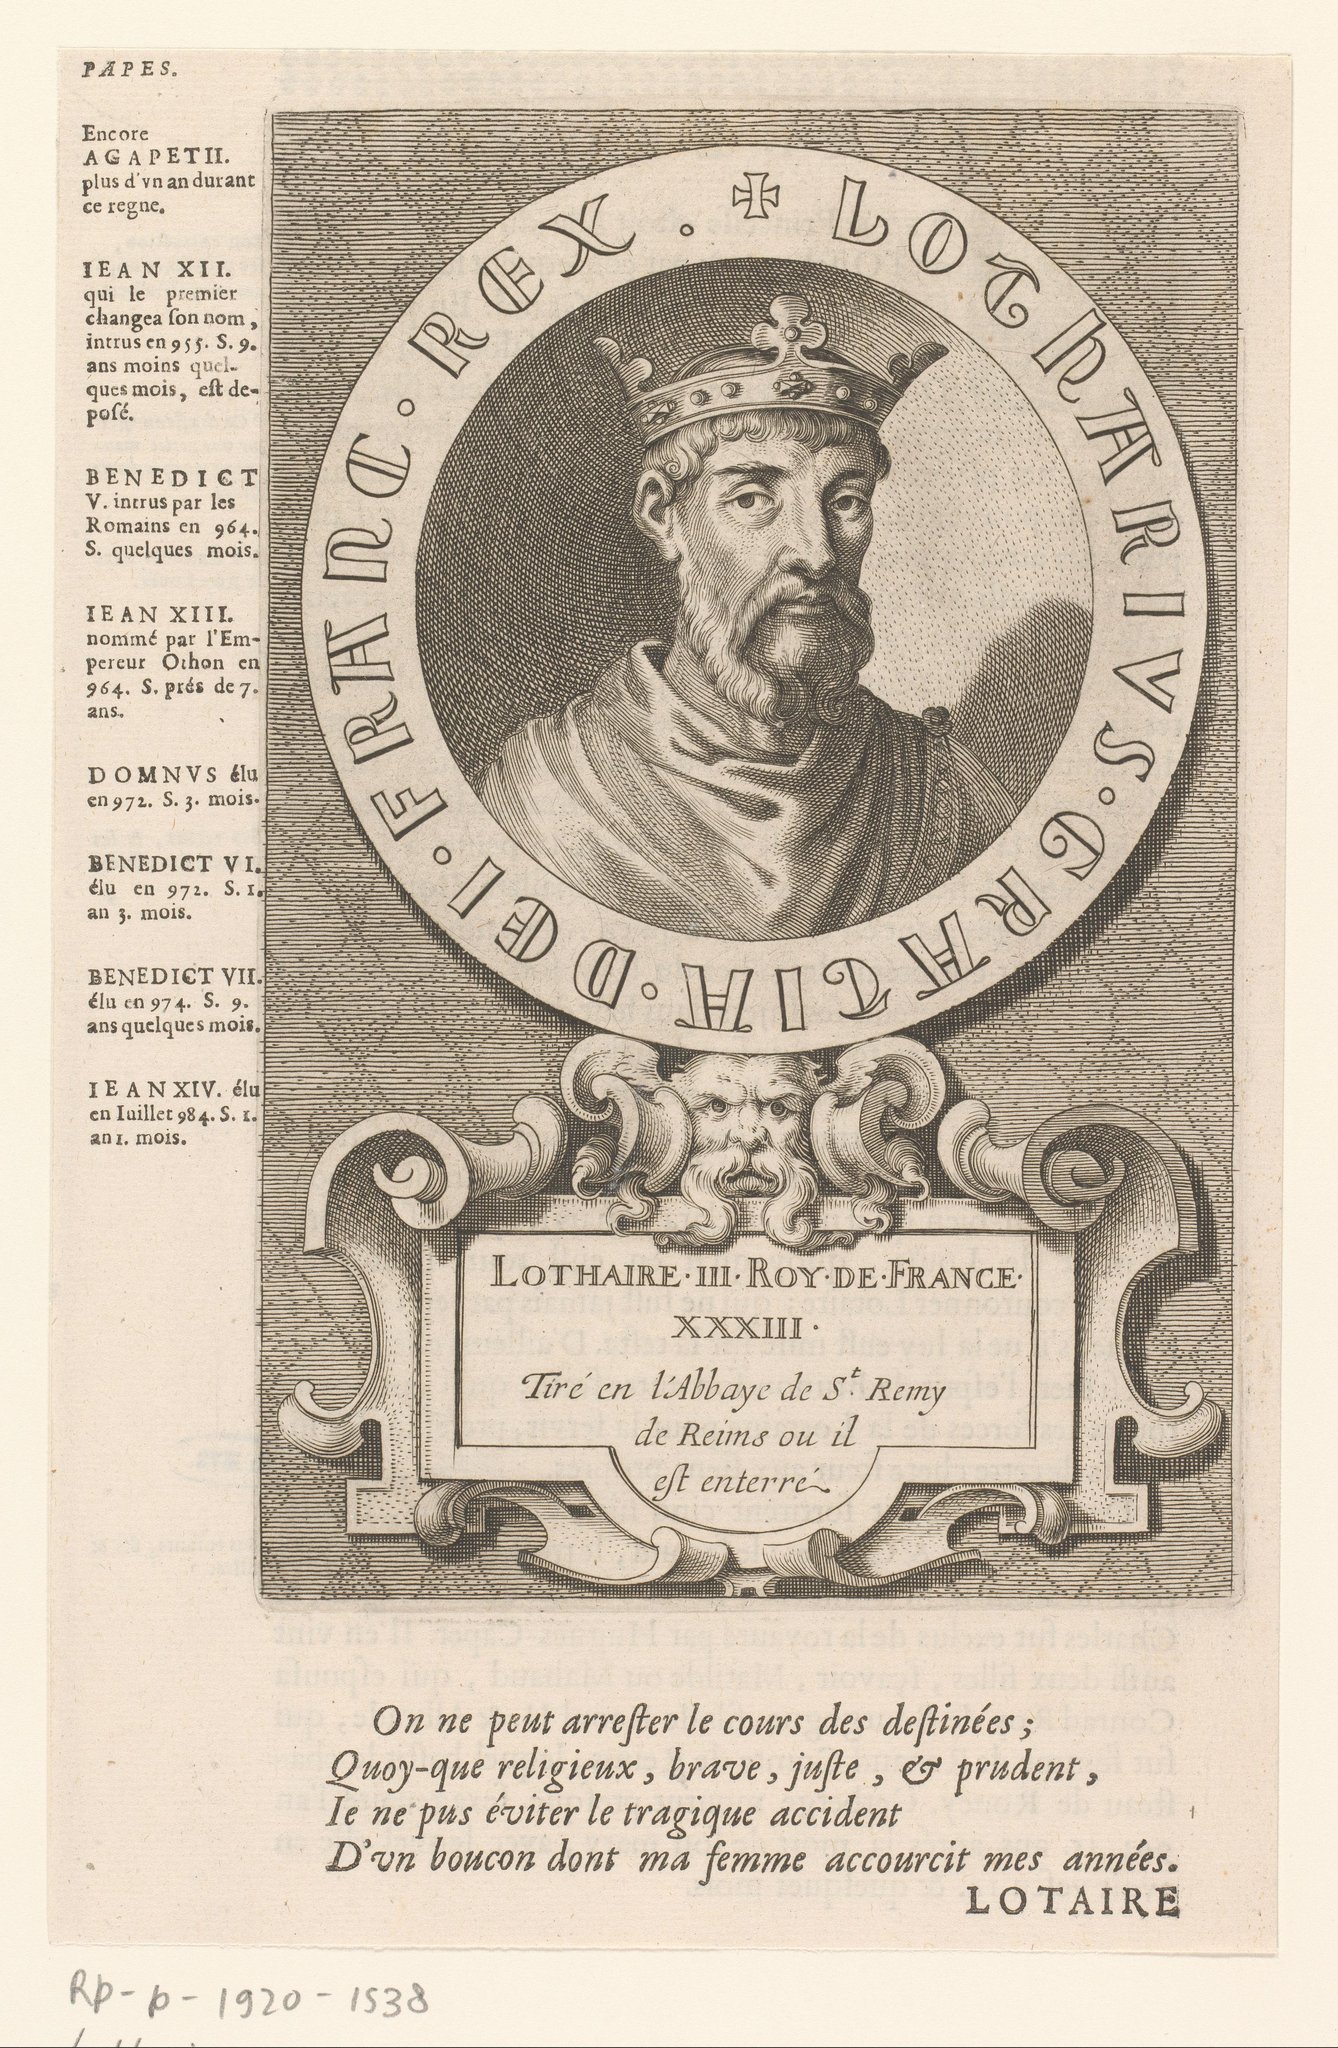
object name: book illustration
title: Portret van Lotharius van Frankrijk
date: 1685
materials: paper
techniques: engraving, letterpress printing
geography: paris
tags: historical persons, king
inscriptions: collector's mark: Lugt 2228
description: Prent uit: Mézeray, François Eudes de. Histoire de France, depuis Faramond jusqu'au regne de Louis le Juste. (...) Parijs: Denis Thierry, Jean Guignard en Claude Barbin, 1685, dl. 1, p. 688.